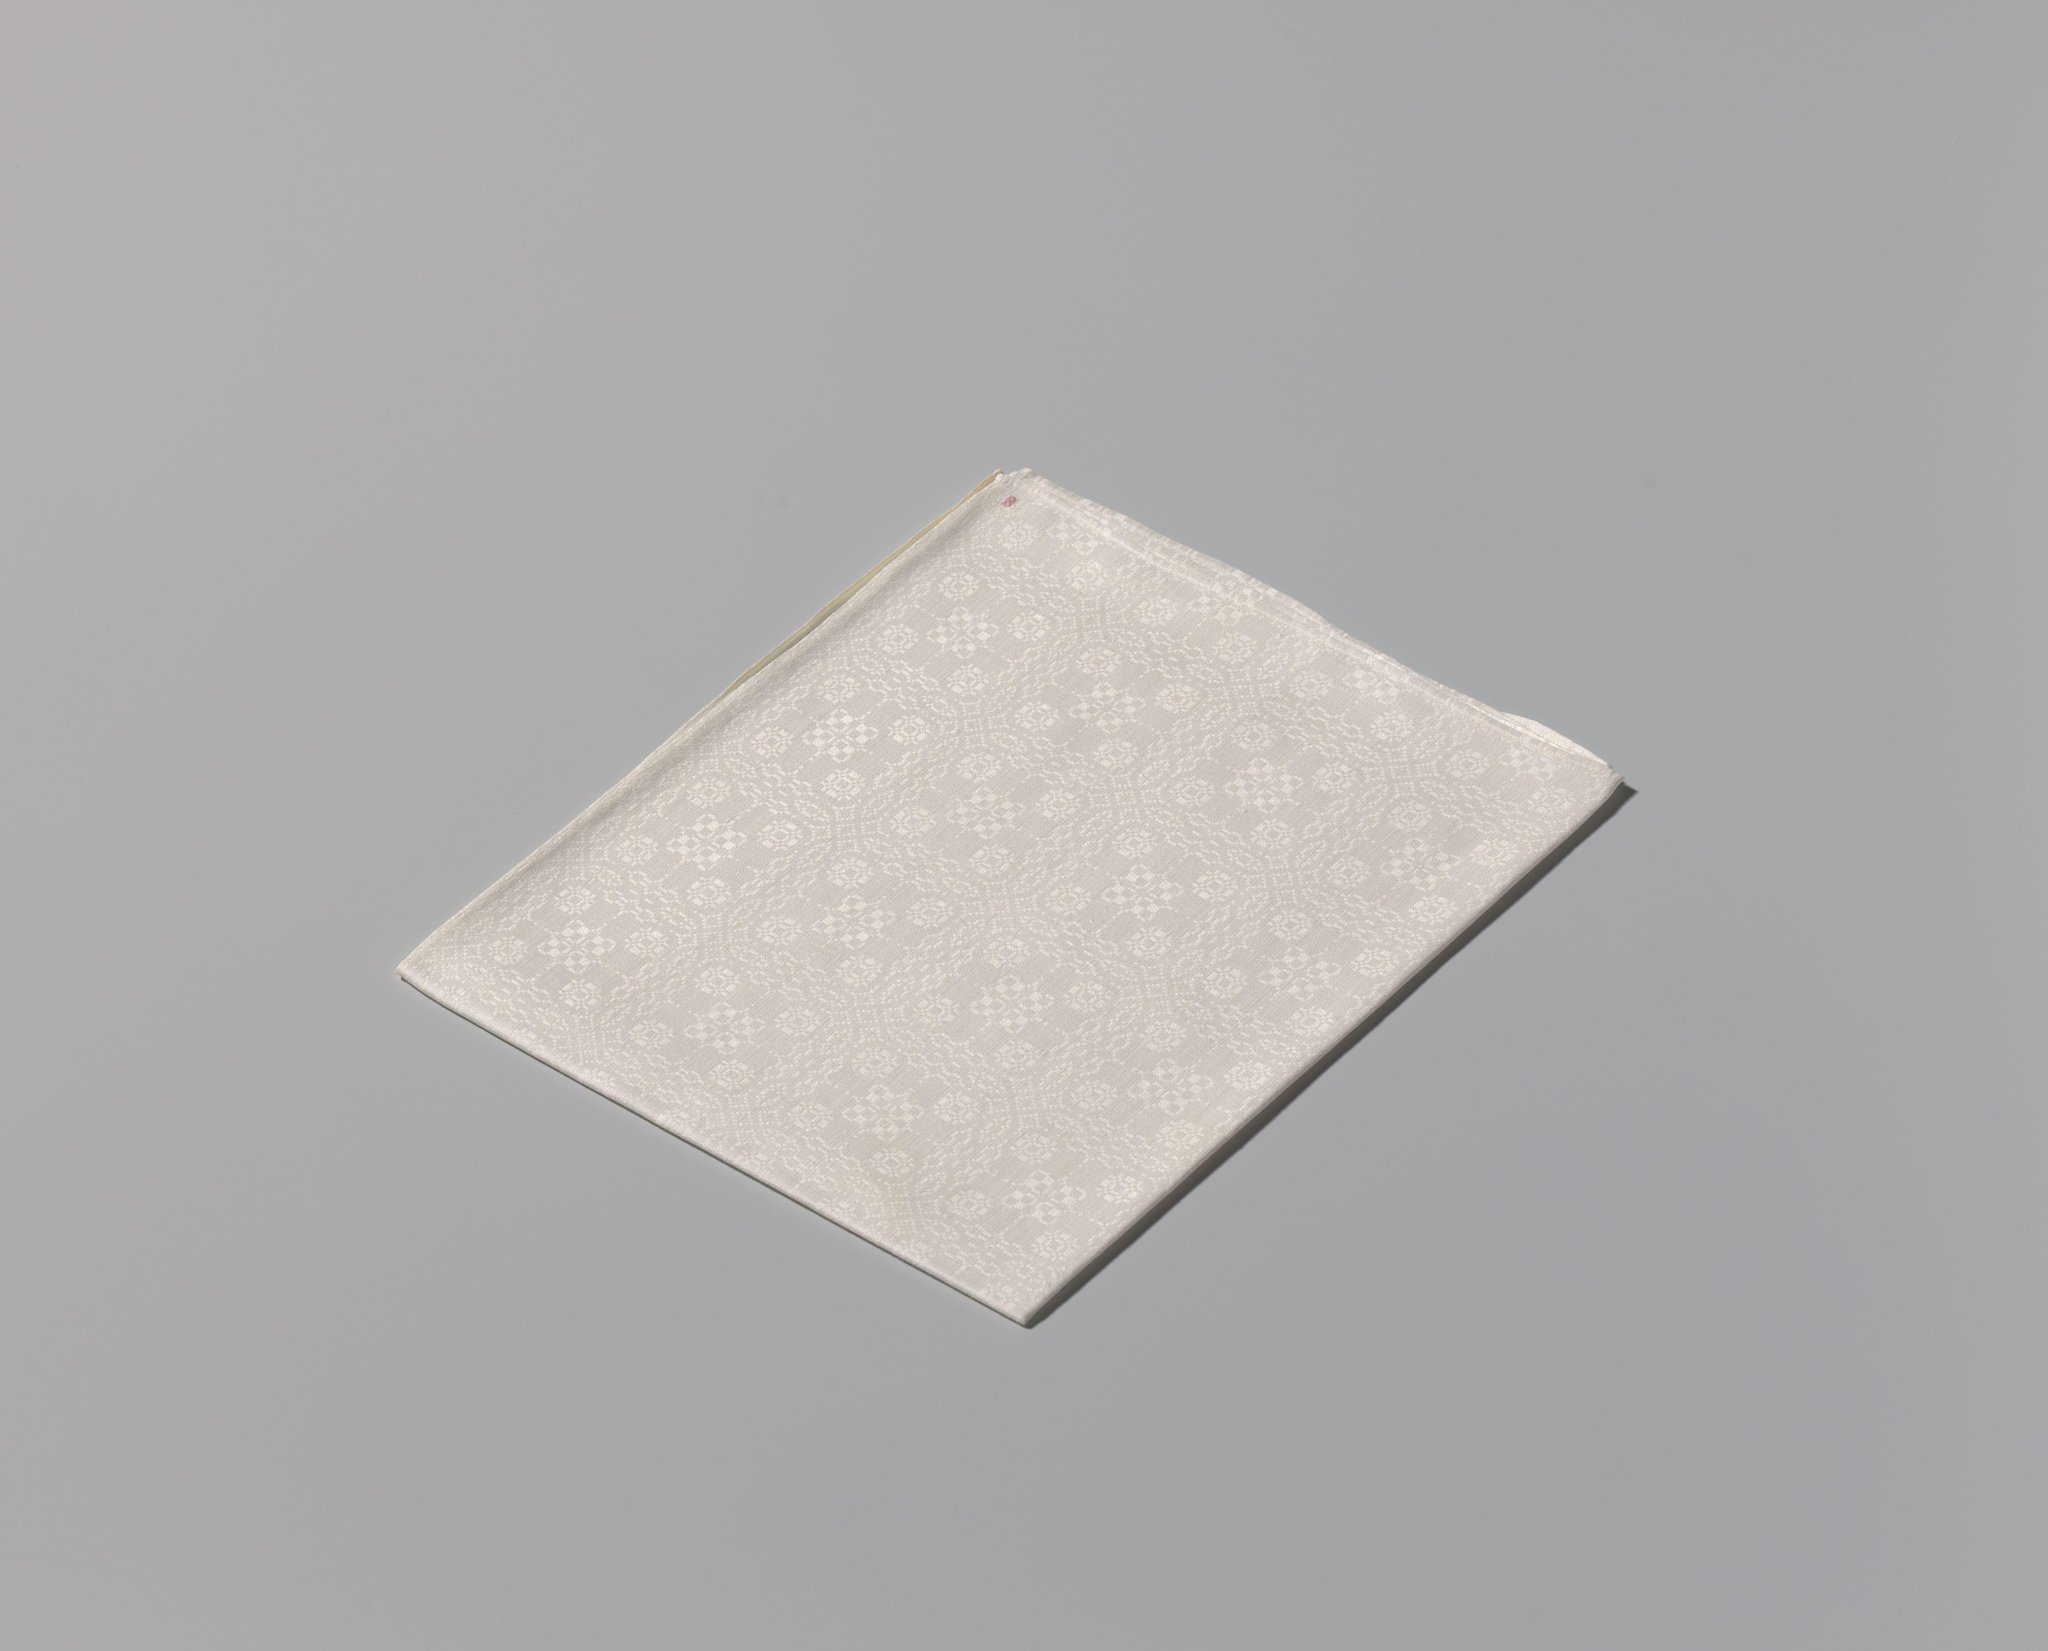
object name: napkin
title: Servet van pellendamast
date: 1675-1725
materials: linen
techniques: weave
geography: north brabant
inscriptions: mark: ‘B’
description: Servet van pellendamast. Elkaar snijdende rijen van ruiten vormen vierkanten, waarbinnen vijf blokken. Het servet is gehalveerd. Het servet hoort bij twaalf servetten en een tafellaken.